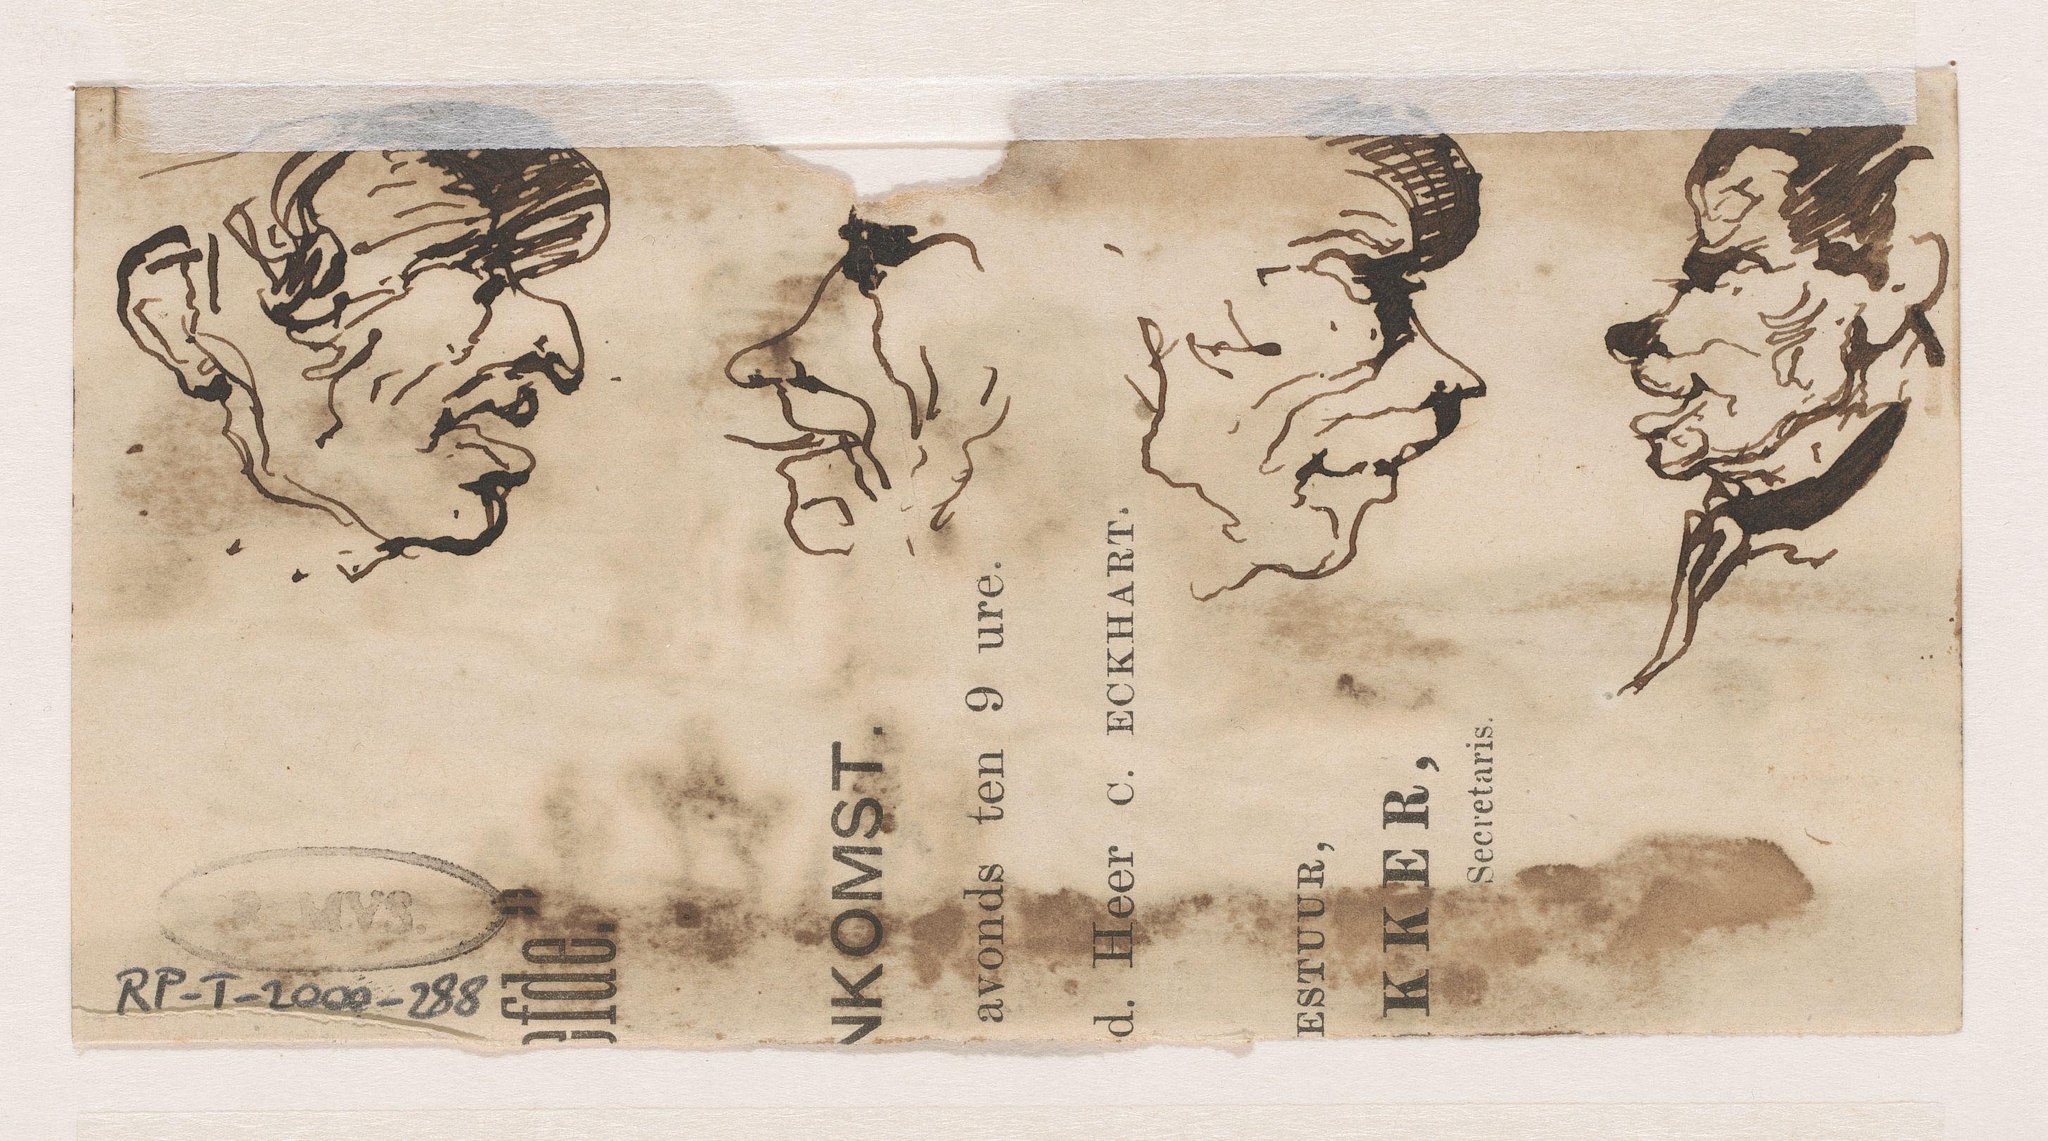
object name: drawing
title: Koppen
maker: johannes tavenraat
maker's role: draughtsman, painter, print maker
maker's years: 1809-1881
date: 1840-1880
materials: ink, paper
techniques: pen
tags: caricatures (human types)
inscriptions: collector's mark: Lugt 2228